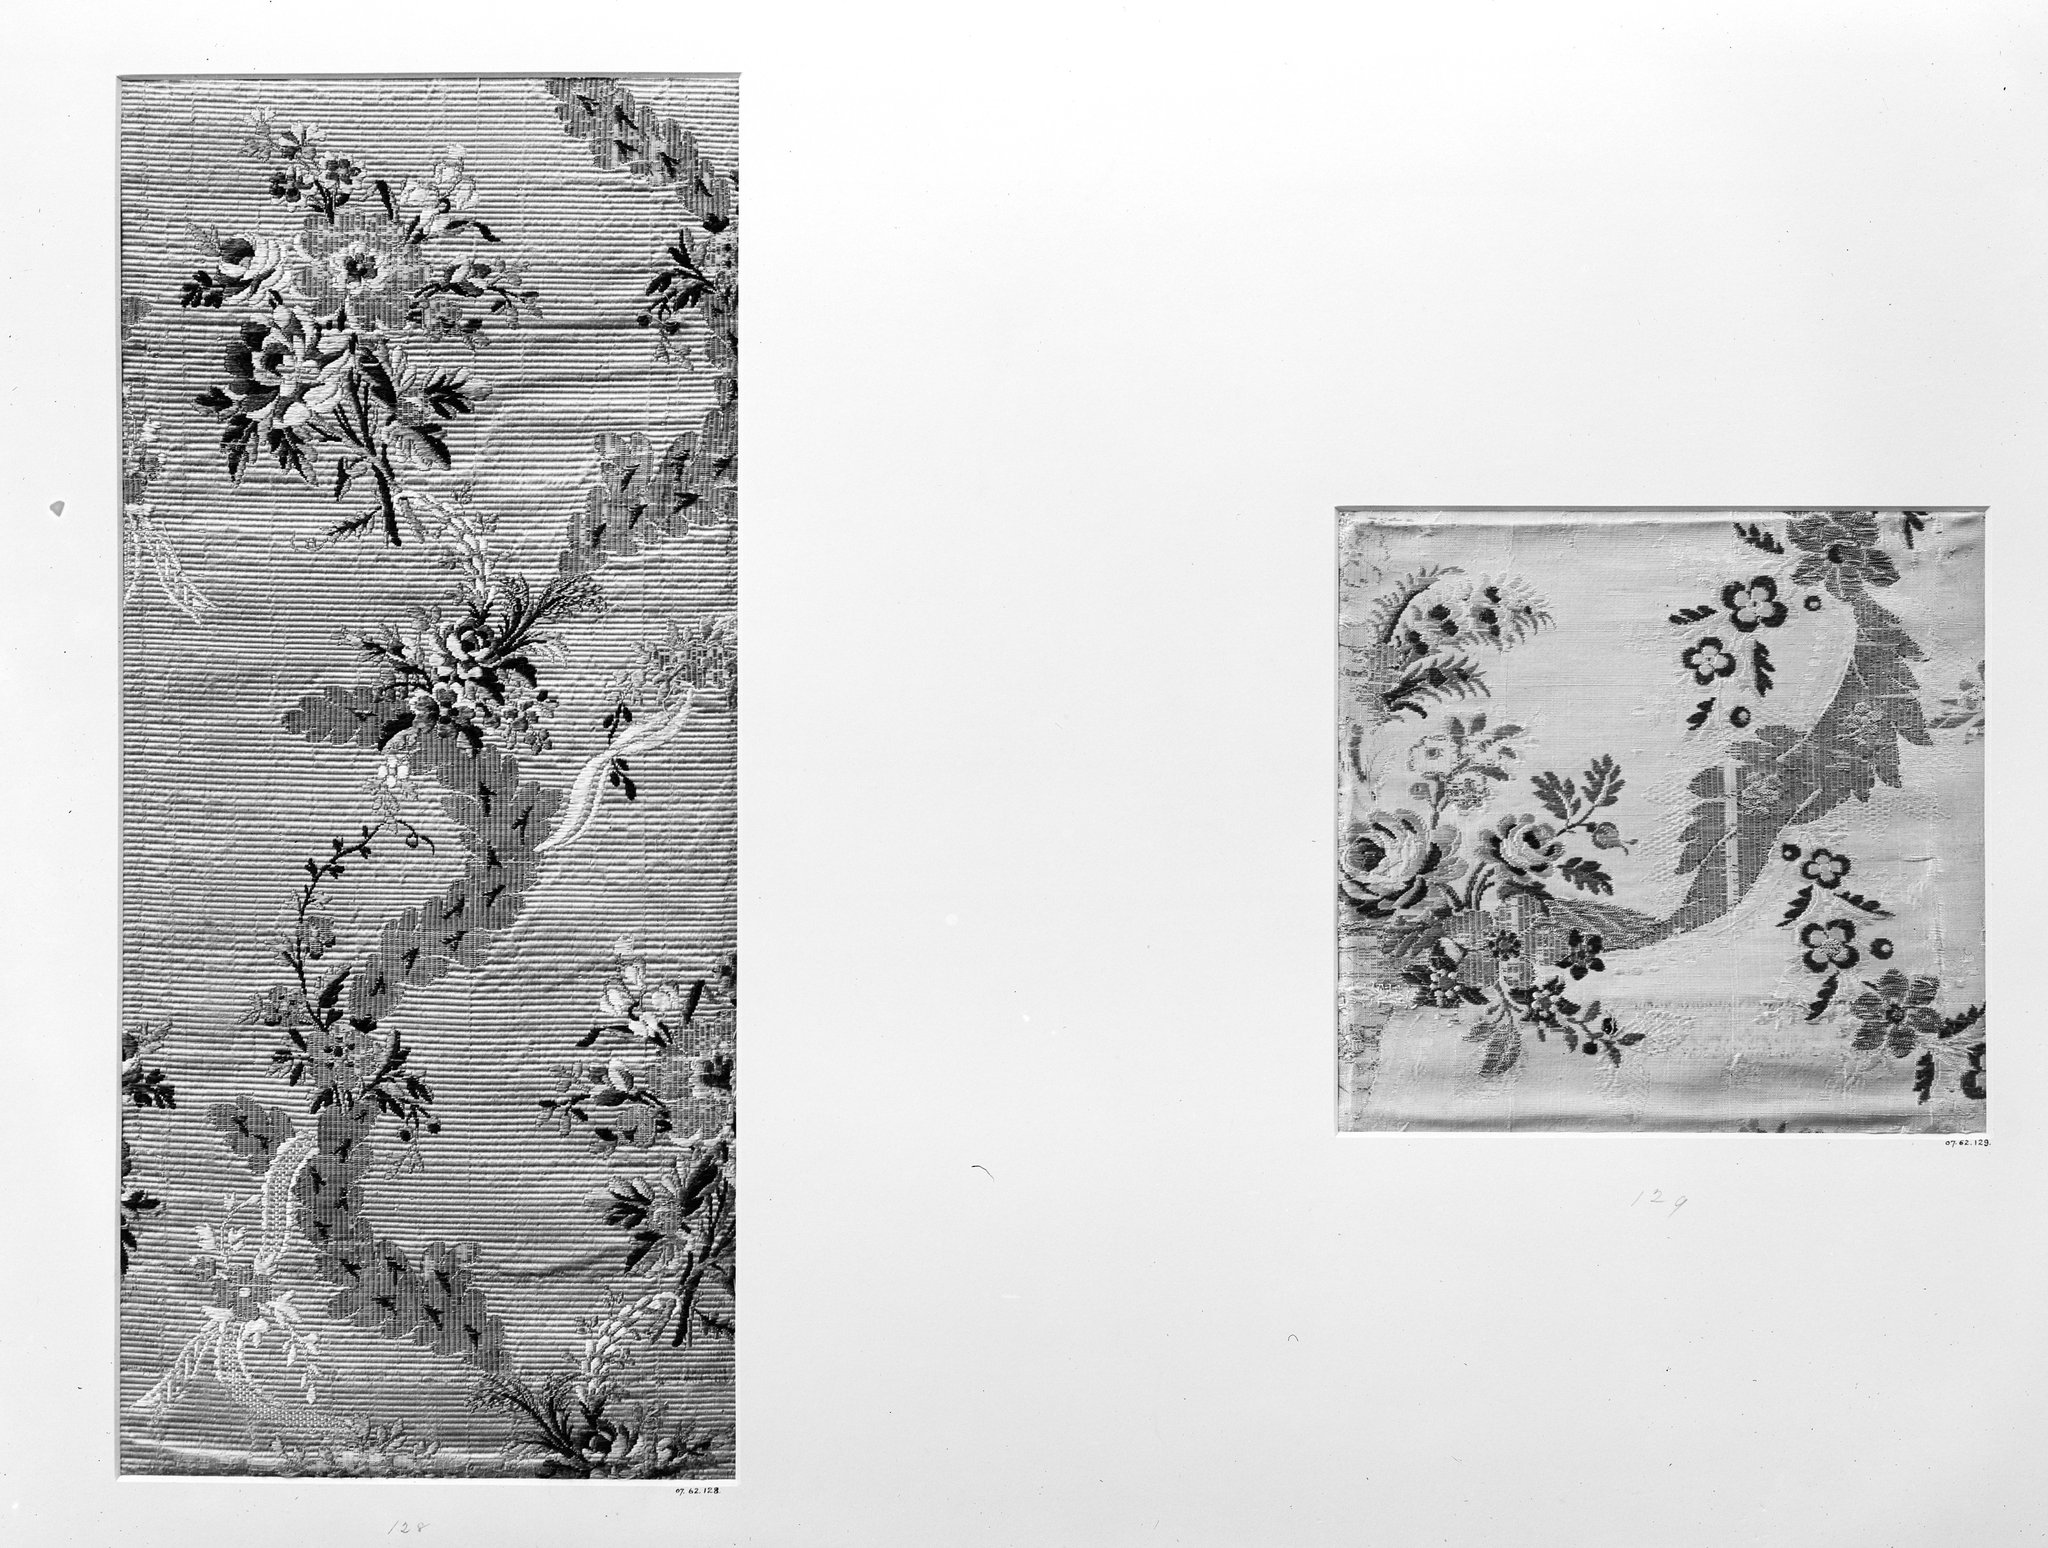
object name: piece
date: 1750-1760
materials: metal thread, silk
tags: flowers,plants